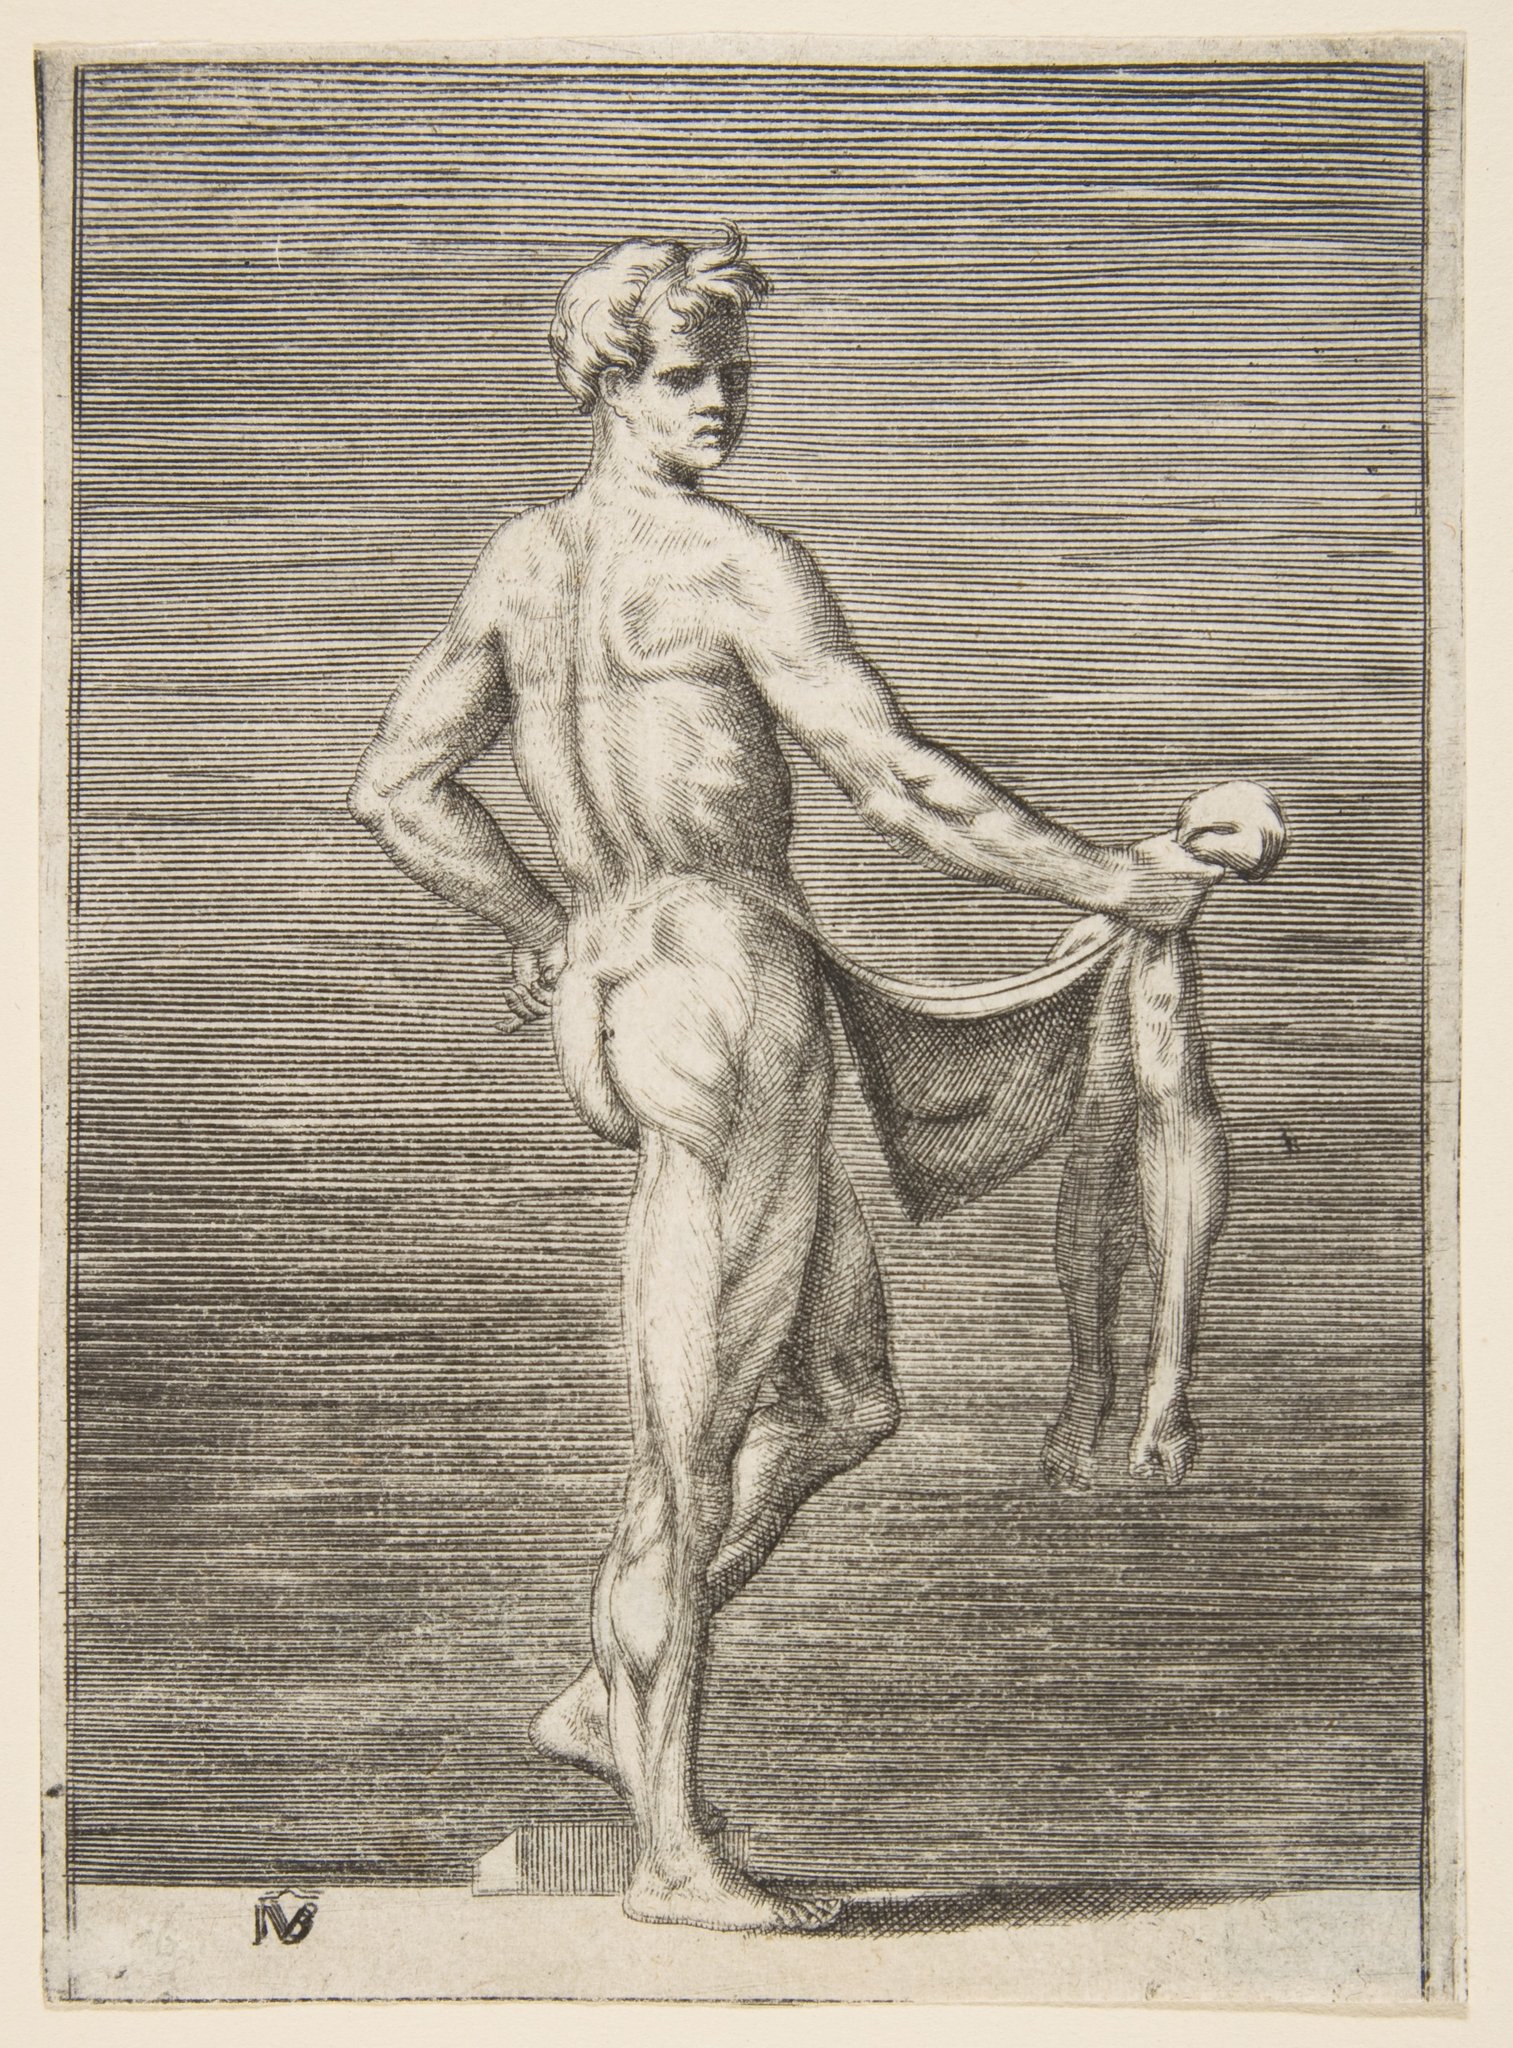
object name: print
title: Flayed man seen from behind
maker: giulio bonasone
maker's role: artist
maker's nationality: italian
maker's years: 1510-1576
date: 1531-1576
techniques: engraving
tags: male nudes